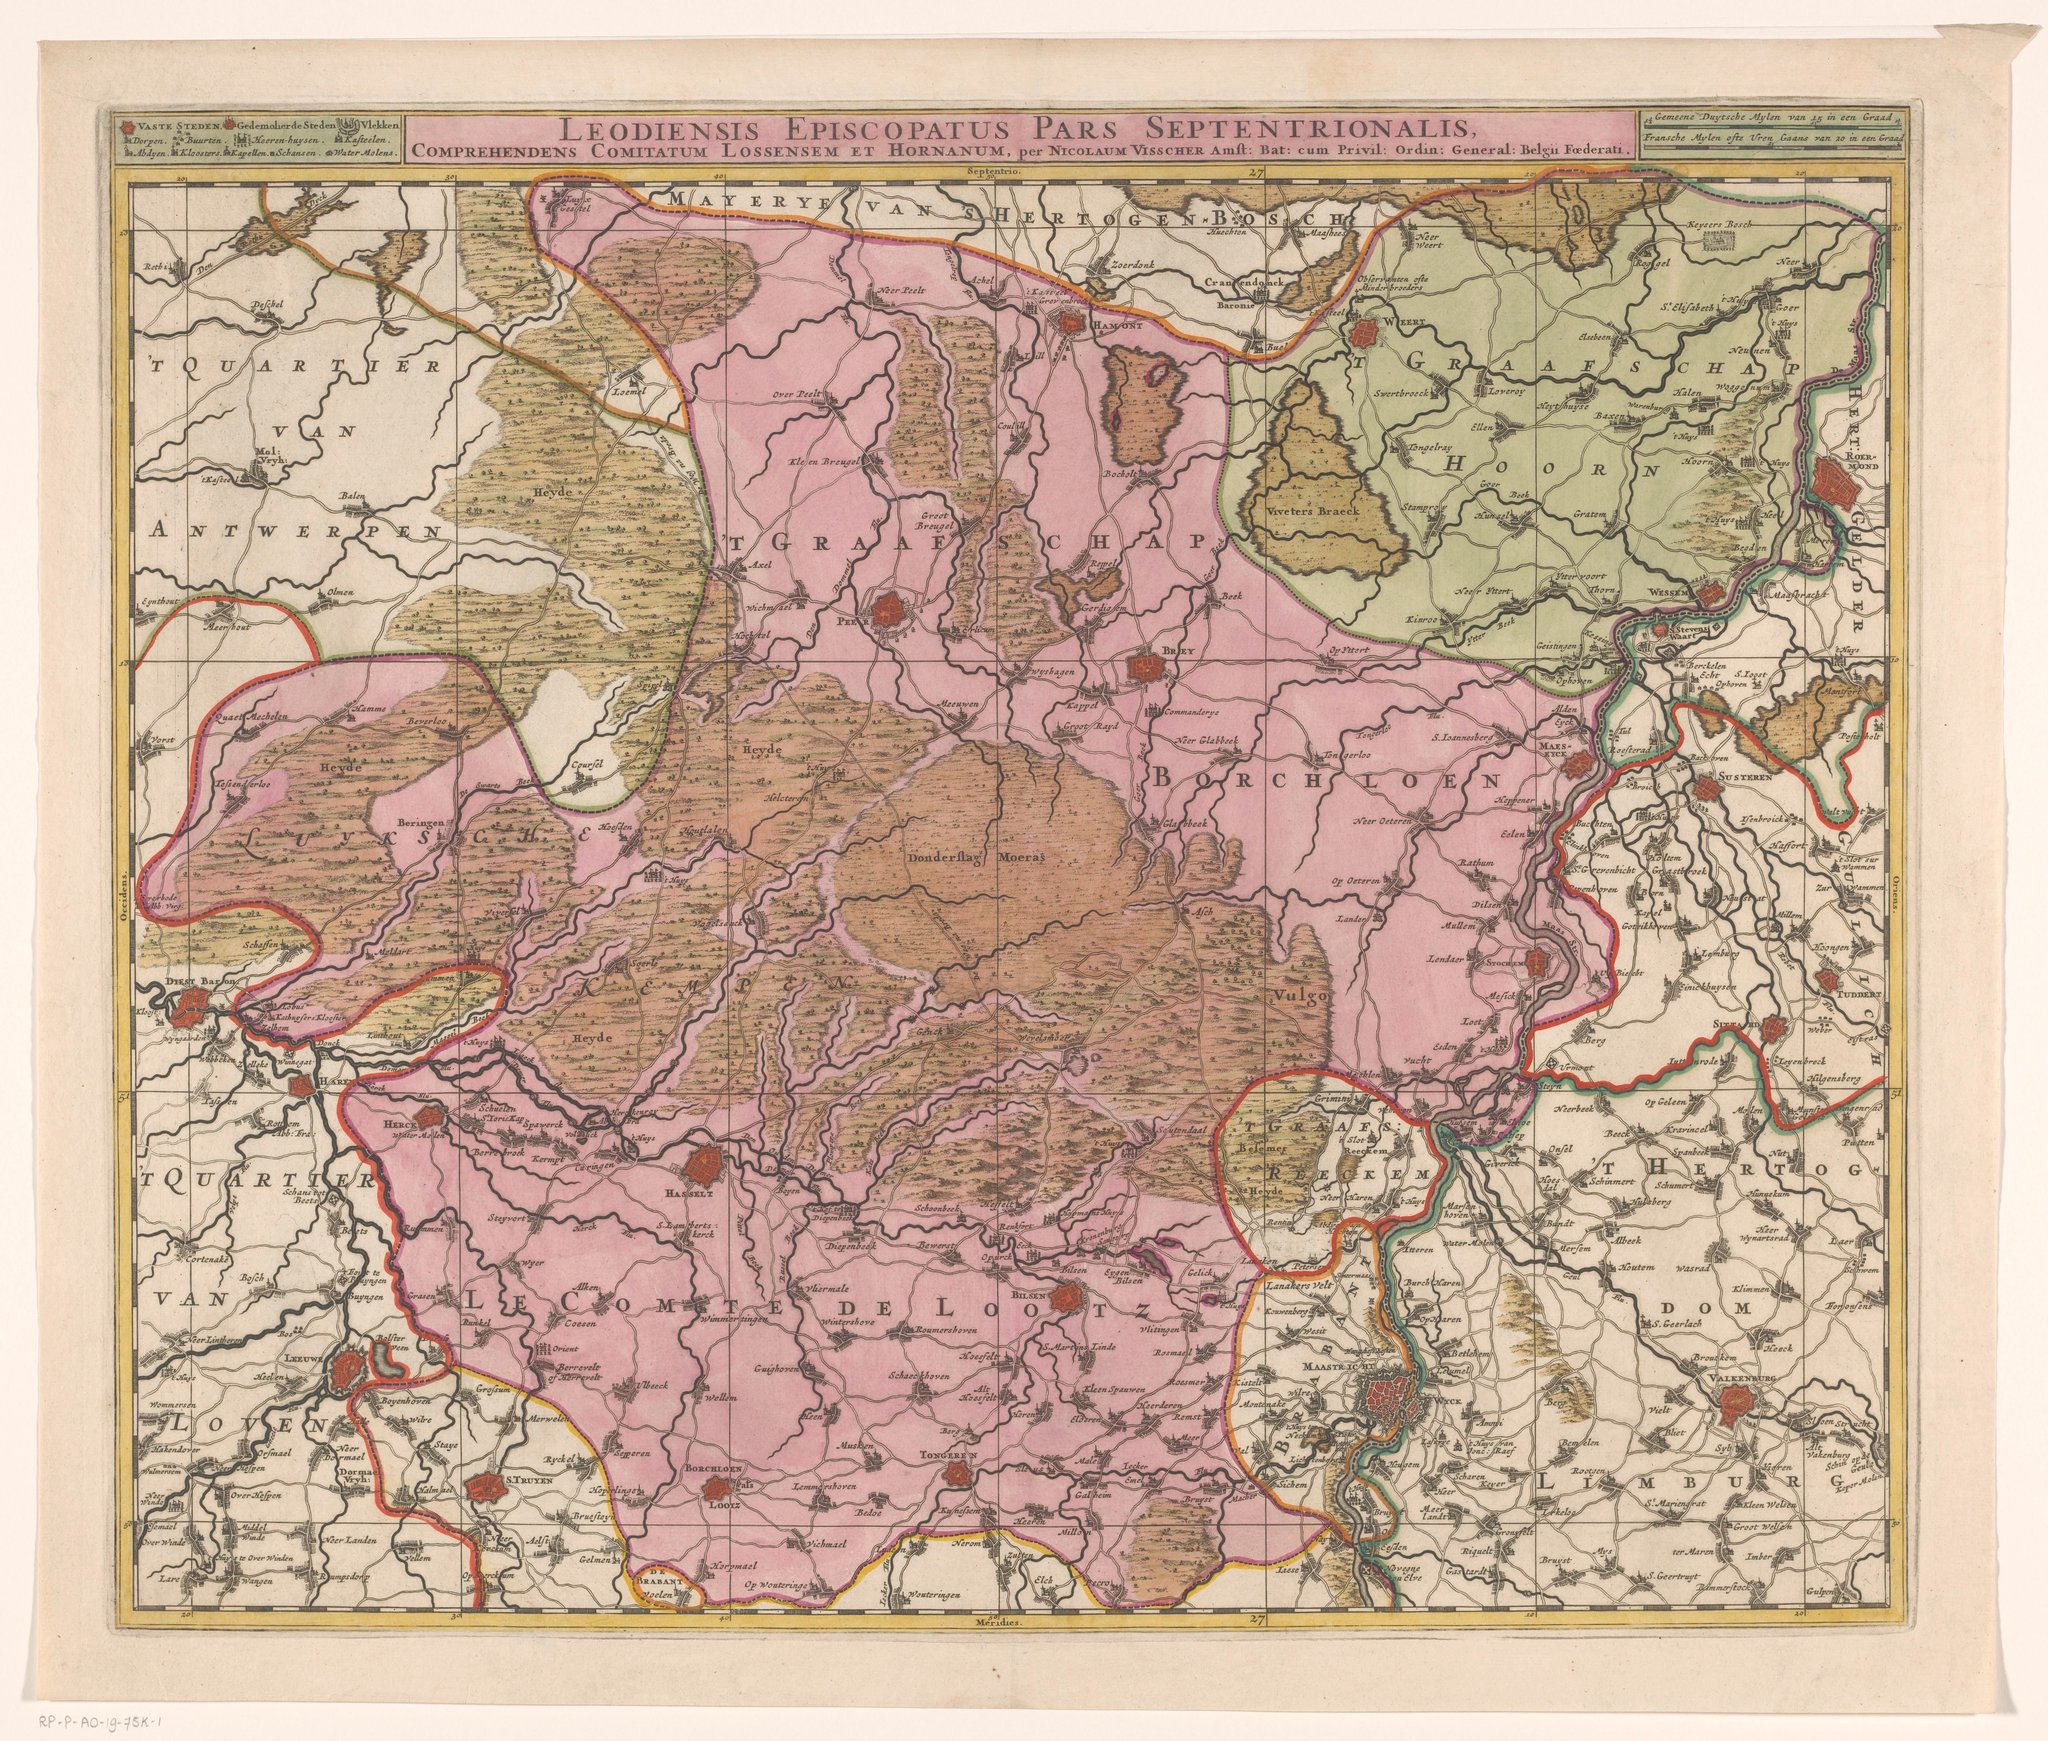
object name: print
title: Leodiensis episcopatus pars septentrionalis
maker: Anonymous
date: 1677-1720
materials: paper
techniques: engraving, etching, hand coloring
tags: maps of separate countries or regions, prince-bishopric of liège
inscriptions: collector's mark: Lugt 2228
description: Kaart van het noordelijk deel van het prinsbisdom Luik. In een balk boven de kaart, in het midden, de titel. Links hiervan een legenda. Rechts van de titel twee schaalstokken: 1 1/2 Gemeene Duytsche Mijlen van 15 in een Graad / 2 Fransche Mylen ofte Uren Gaans van 20 in een Graad. De kaart is voorzien van een coördinaten-net en een gradenverdeling.